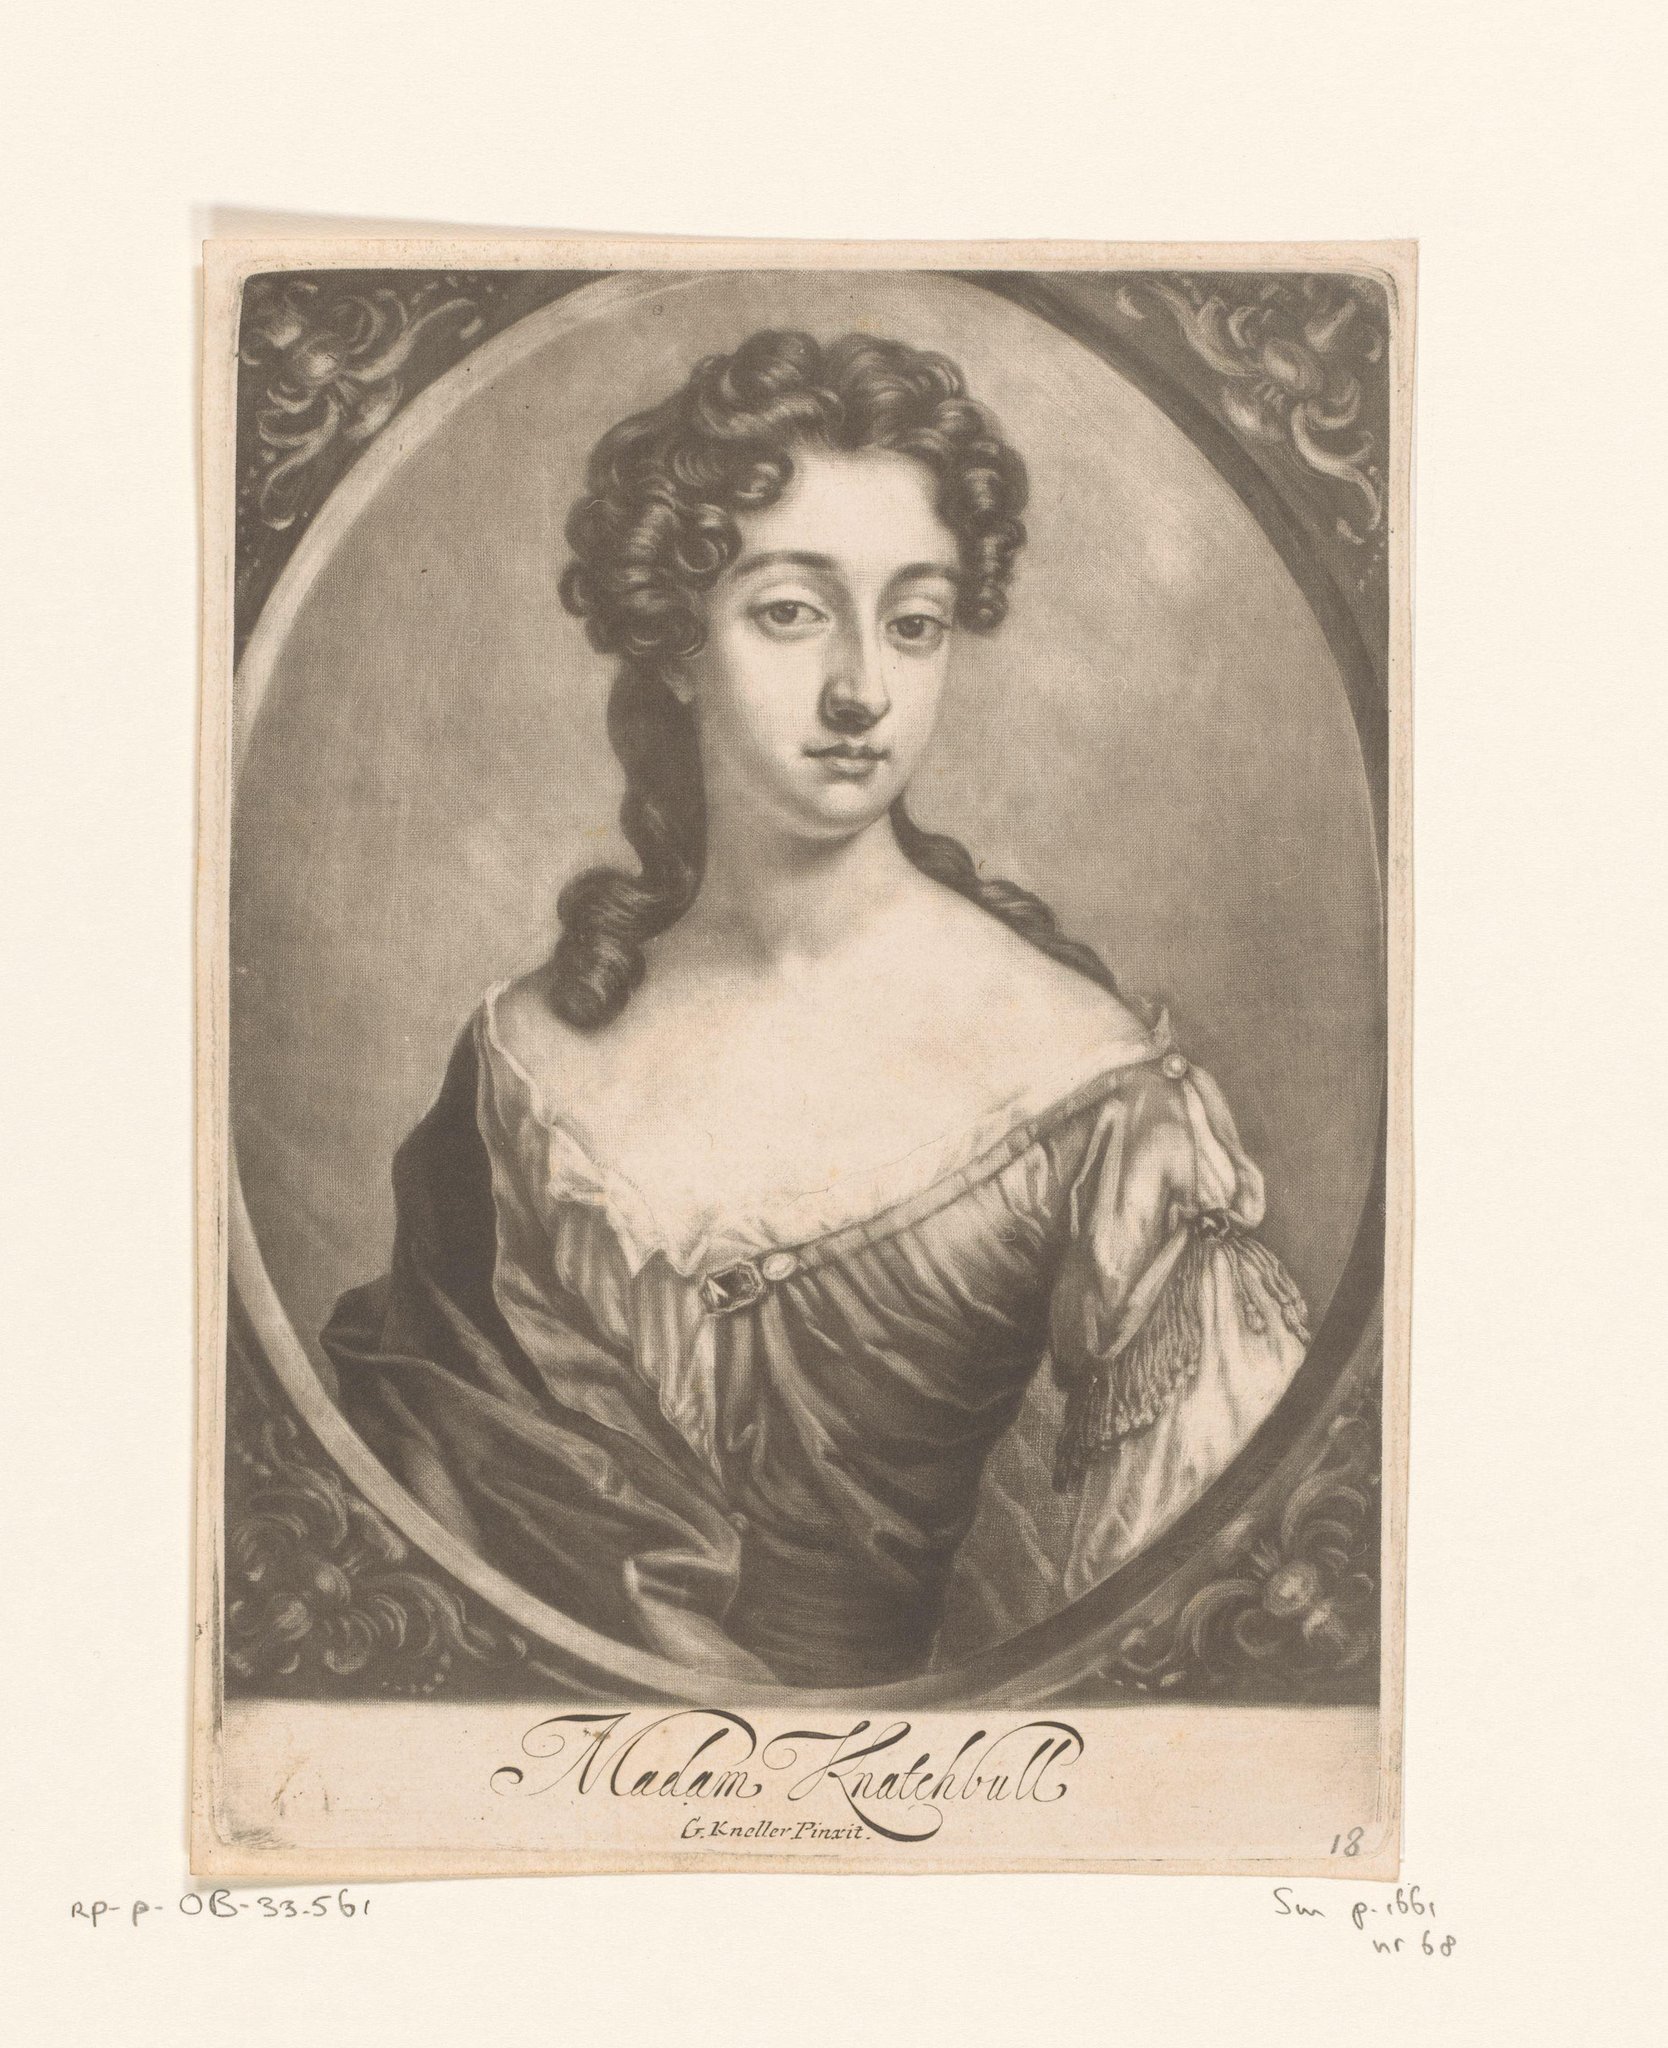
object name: print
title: Madam Knatchbull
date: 1680-1700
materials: paper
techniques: mezzotint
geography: england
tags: historical persons - bb - woman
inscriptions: collector's mark: Lugt 240